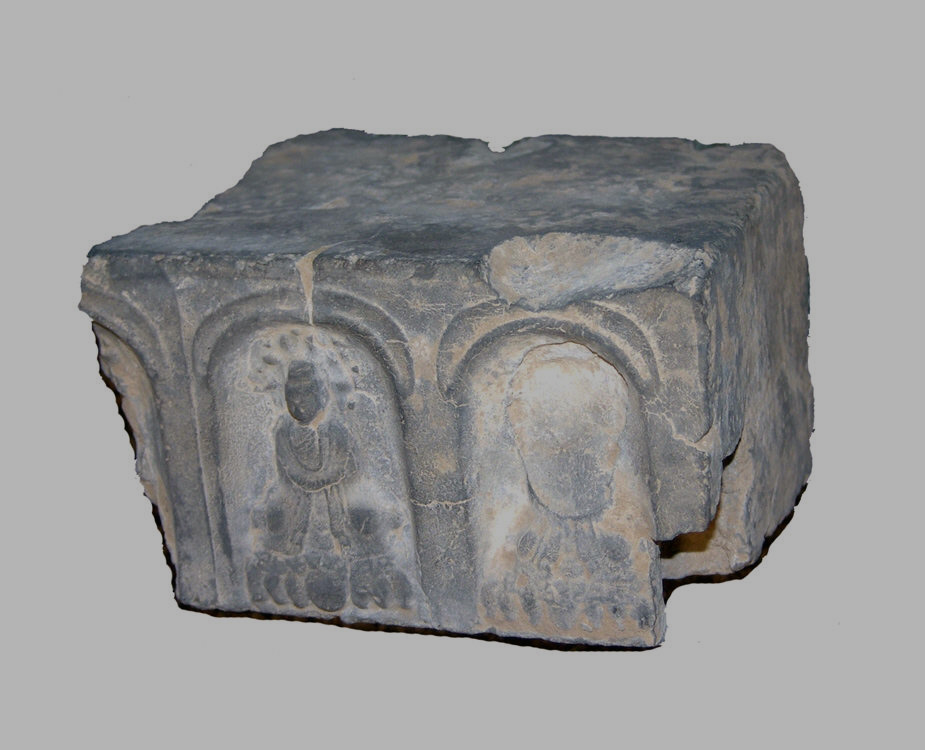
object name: tile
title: Tile with Buddhist images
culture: chinese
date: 501-600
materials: earthenware